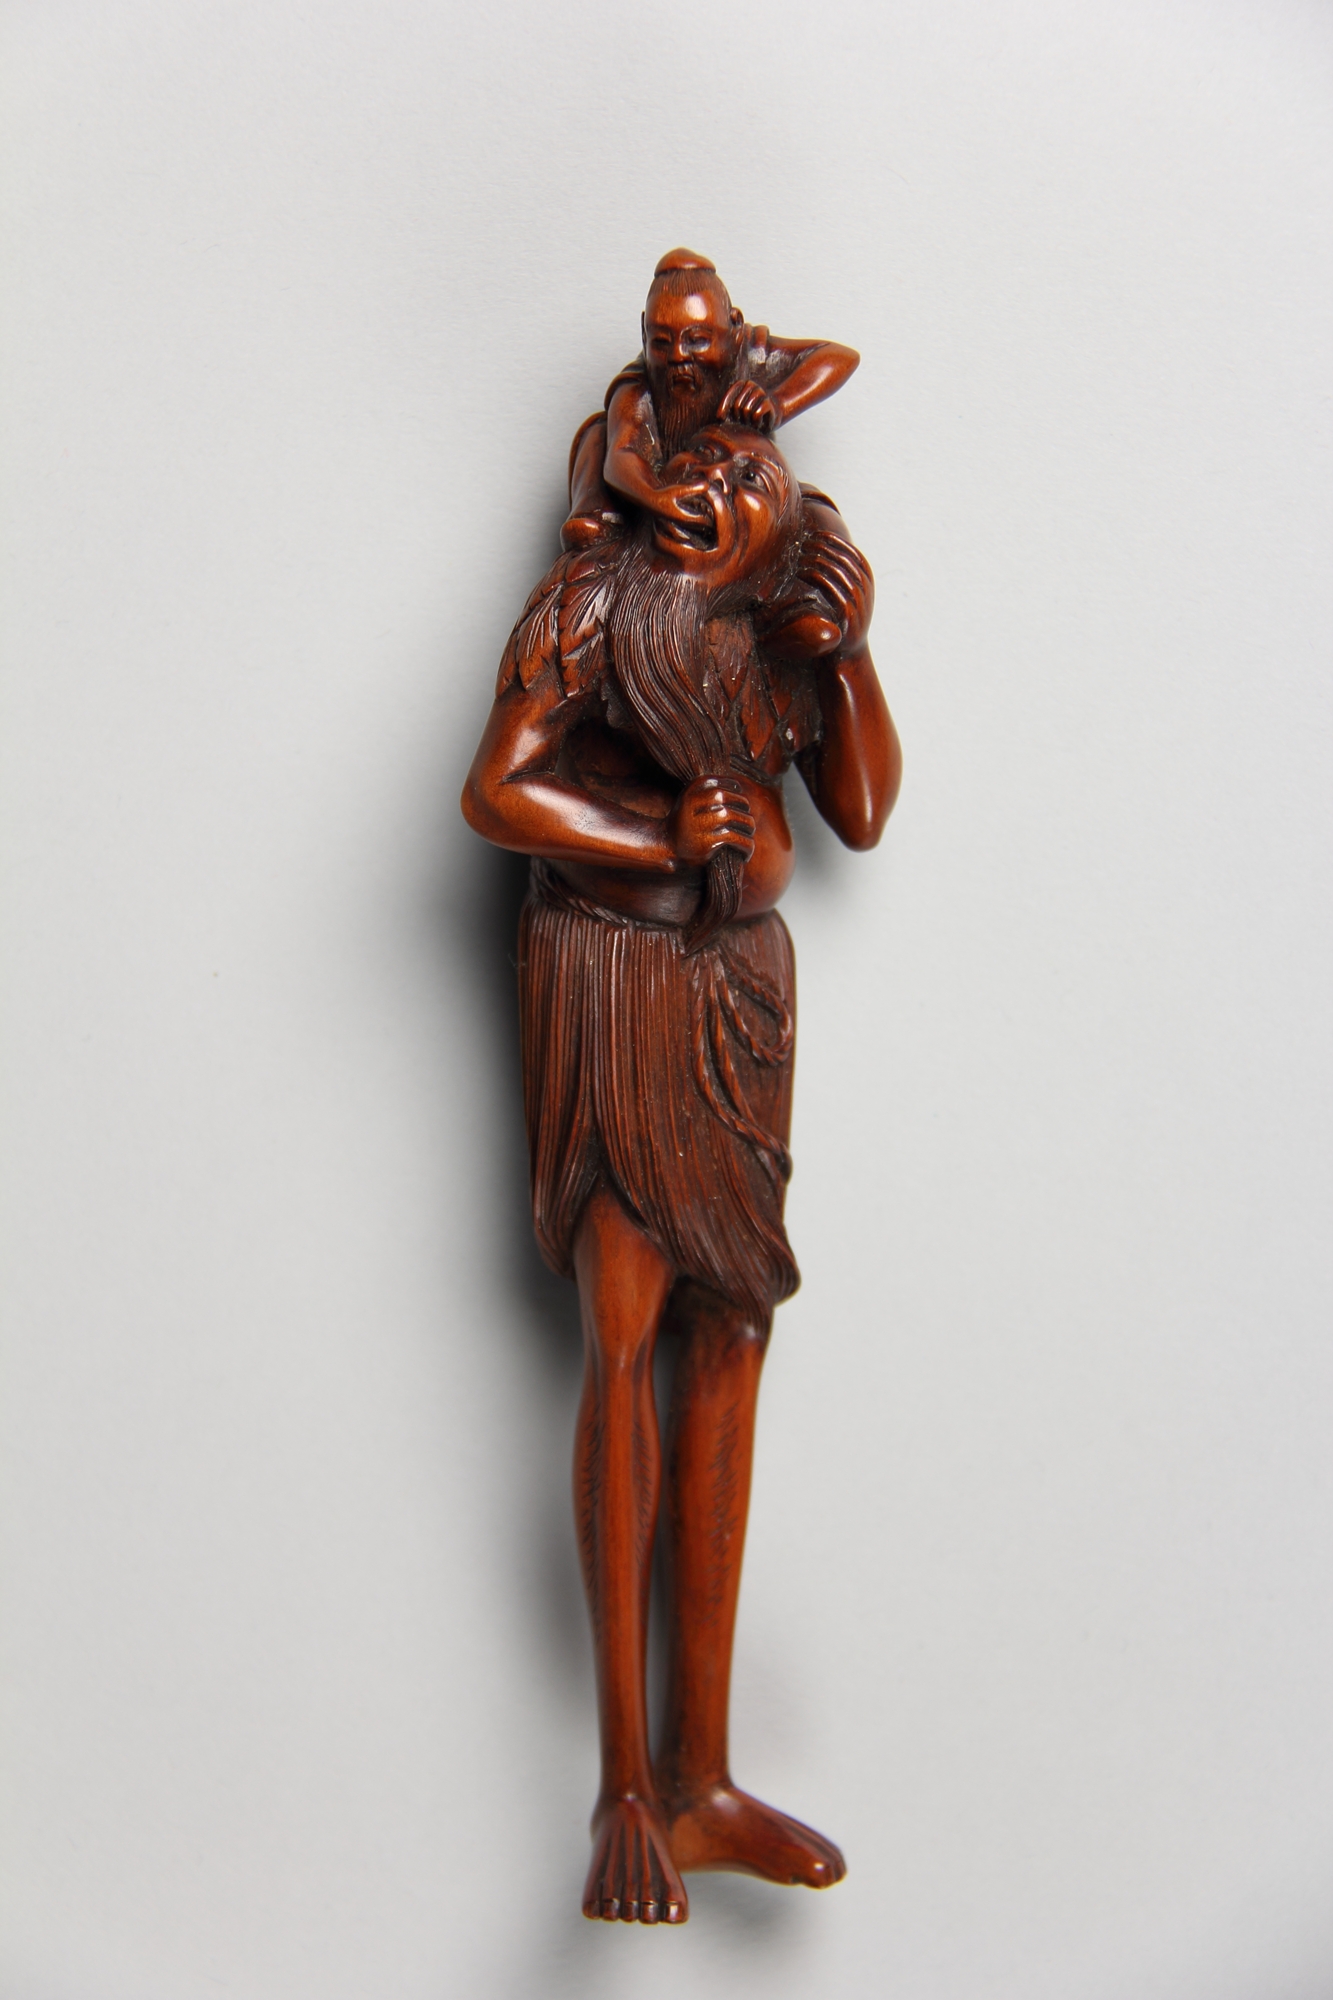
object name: netsuke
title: Ashinaga (Long Legs) and a Daoist Sage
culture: japanese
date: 1701-1800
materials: wood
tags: men